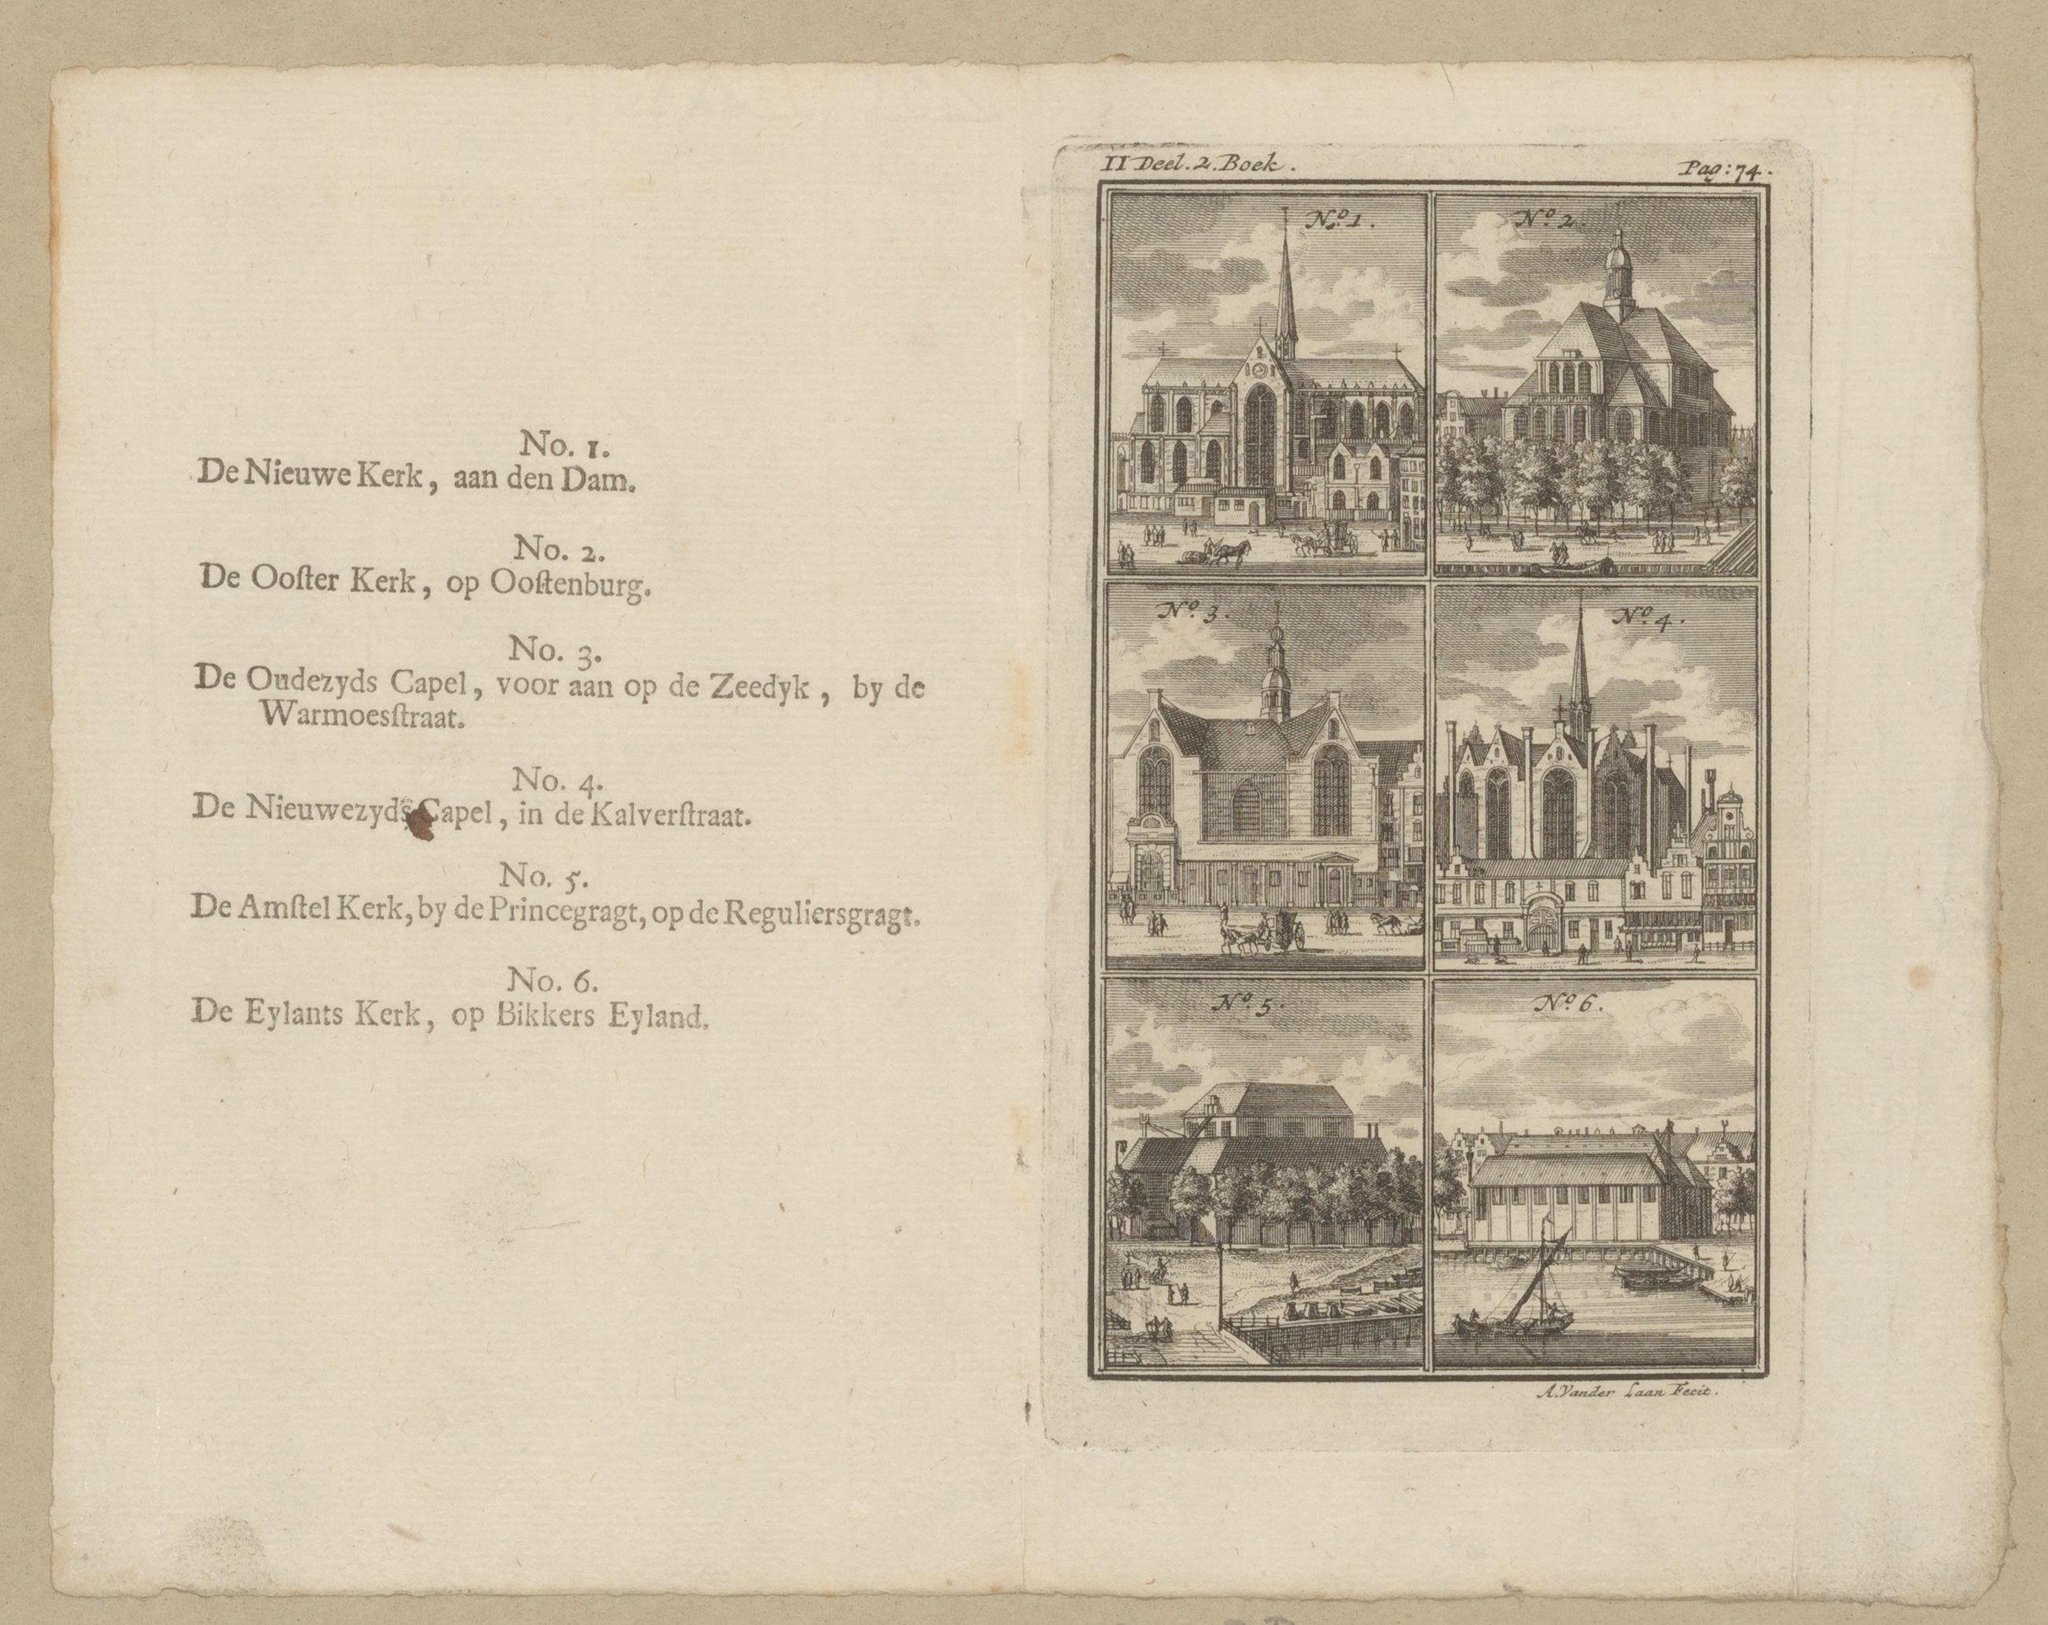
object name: book illustration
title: Zes verschillende kerken en kapellen te Amsterdam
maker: adolf van der laan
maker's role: draughtsman, print maker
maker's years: 1689-1742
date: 1723-1730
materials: paper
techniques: etching, letterpress printing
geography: northern netherlands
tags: church (exterior), city-view, and landscape with man-made constructions (+ city(-scape) with figures, staffage), canals, waters (in city) (+ city(-scape) with figures, staffage)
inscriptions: collector's mark: Lugt 1641b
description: Individuele voorstellingen van Nieuwe Kerk, Oosterkerk, Oudezijds Kapel, Nieuwezijds Kapel, Amstelkerk en Eilandskerk, genummerd van N° 1 tot en met N° 6. Bovenaan gemerkt: II. Deel. 2. Boek. / Pag: 74. Onderwerpsrubriek binnen de Atlas Amsterdam: Kerkwezen: Verzamelbladen protestantse kerken.